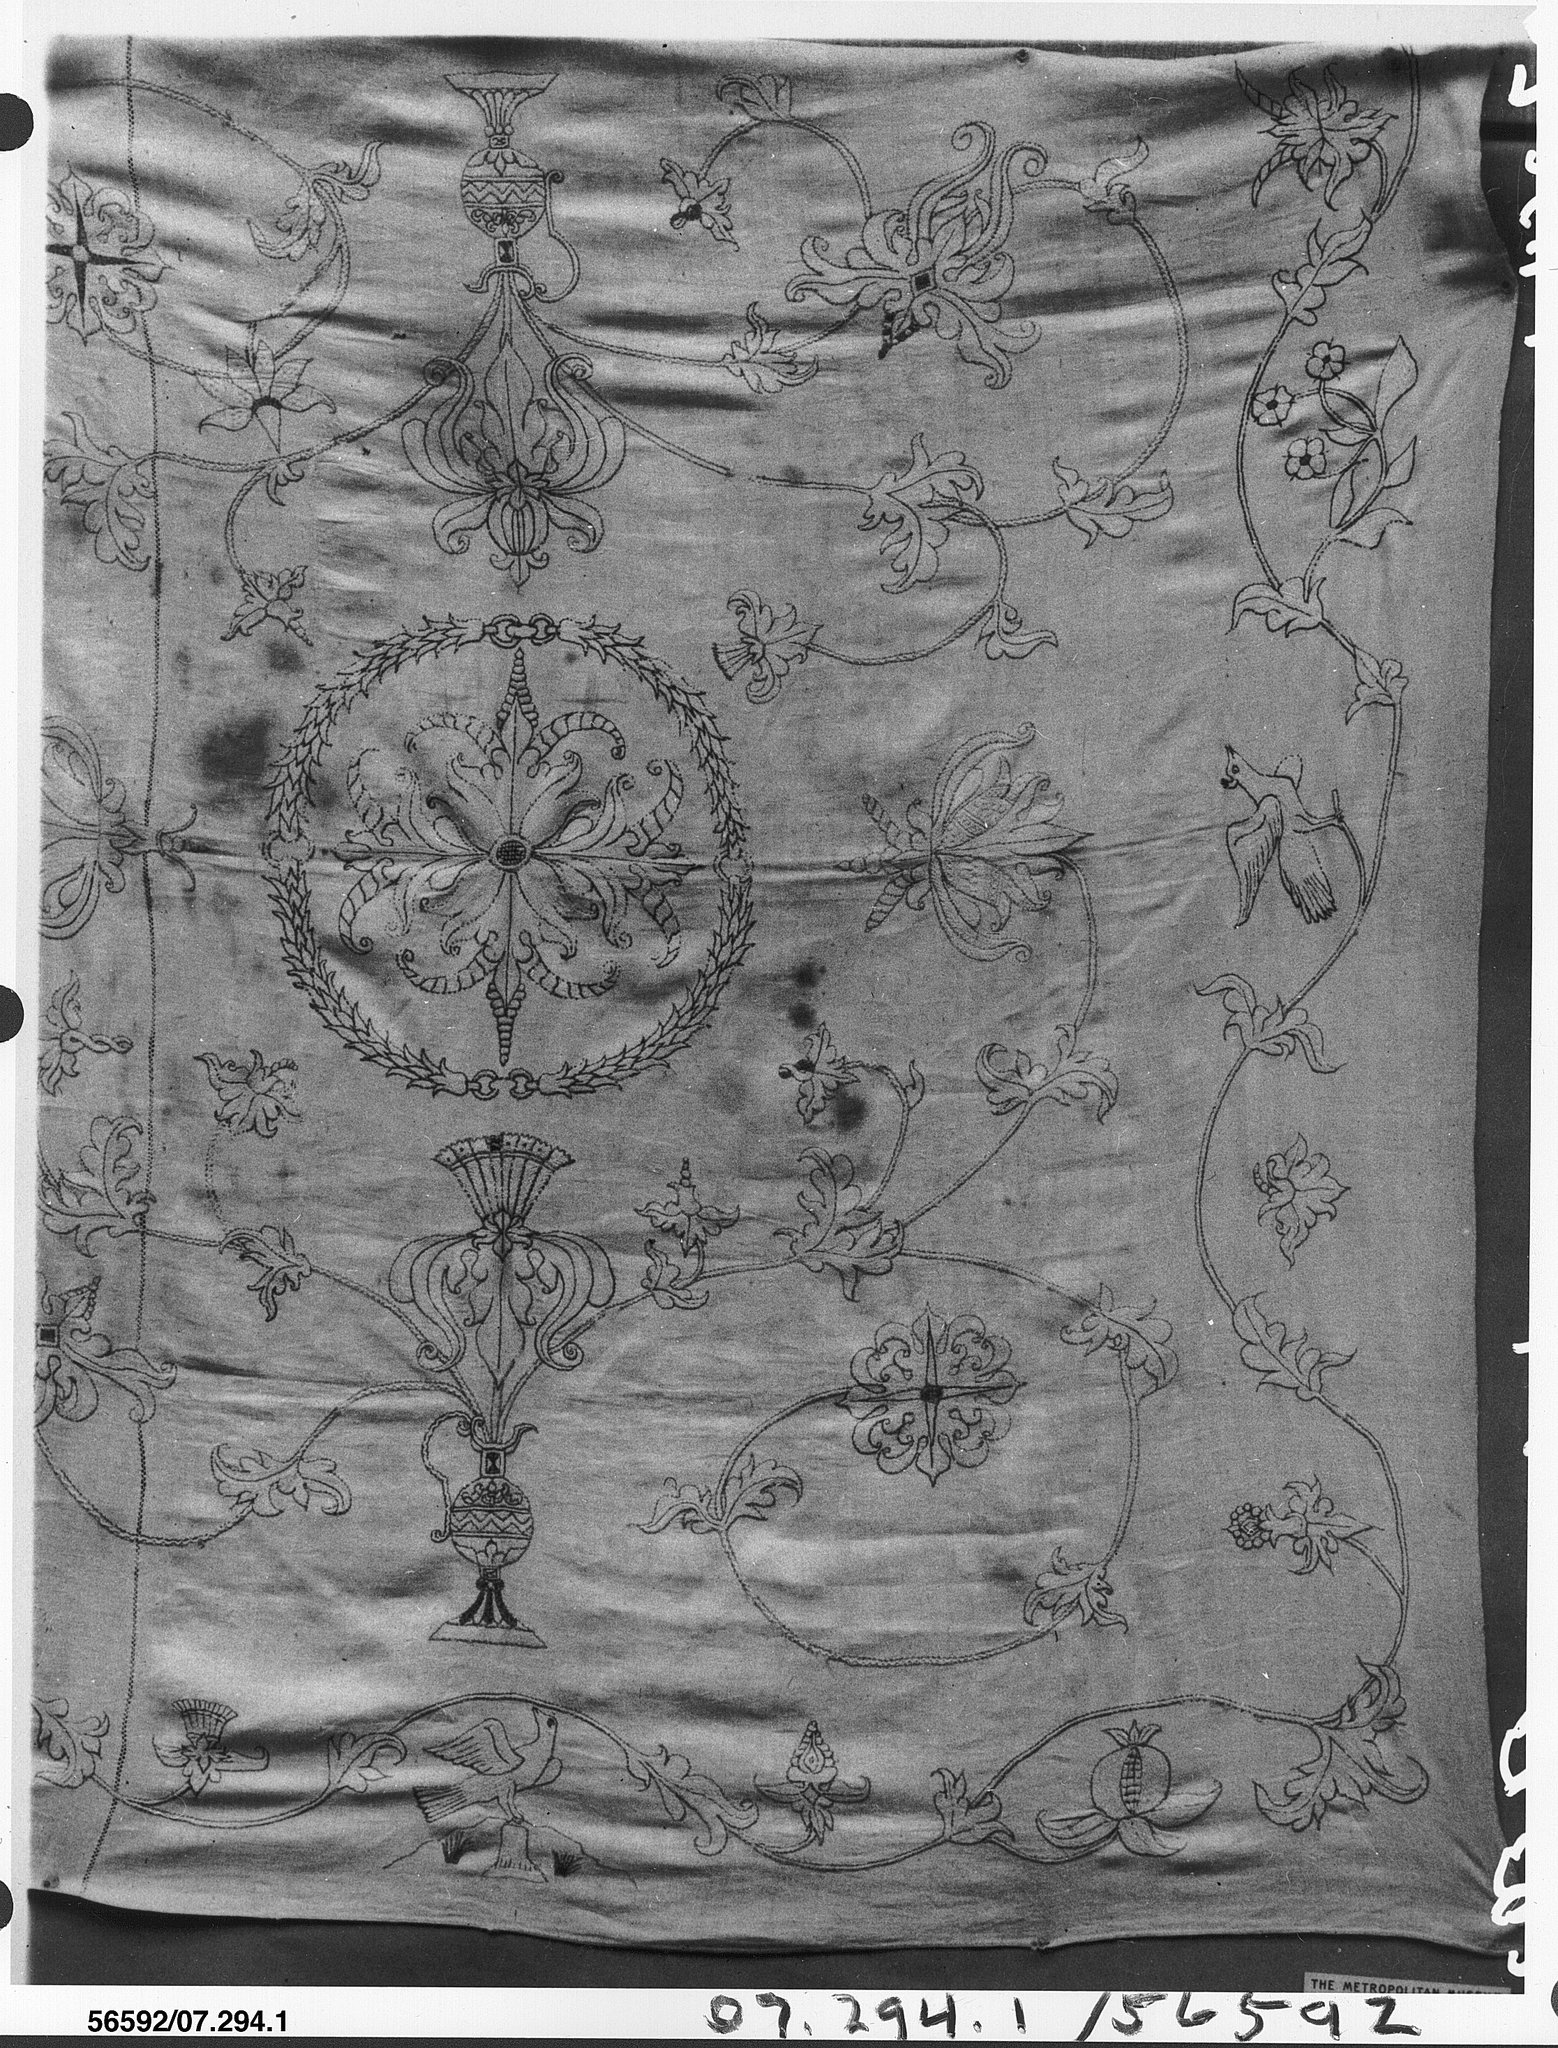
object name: cover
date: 1501-1600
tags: birds